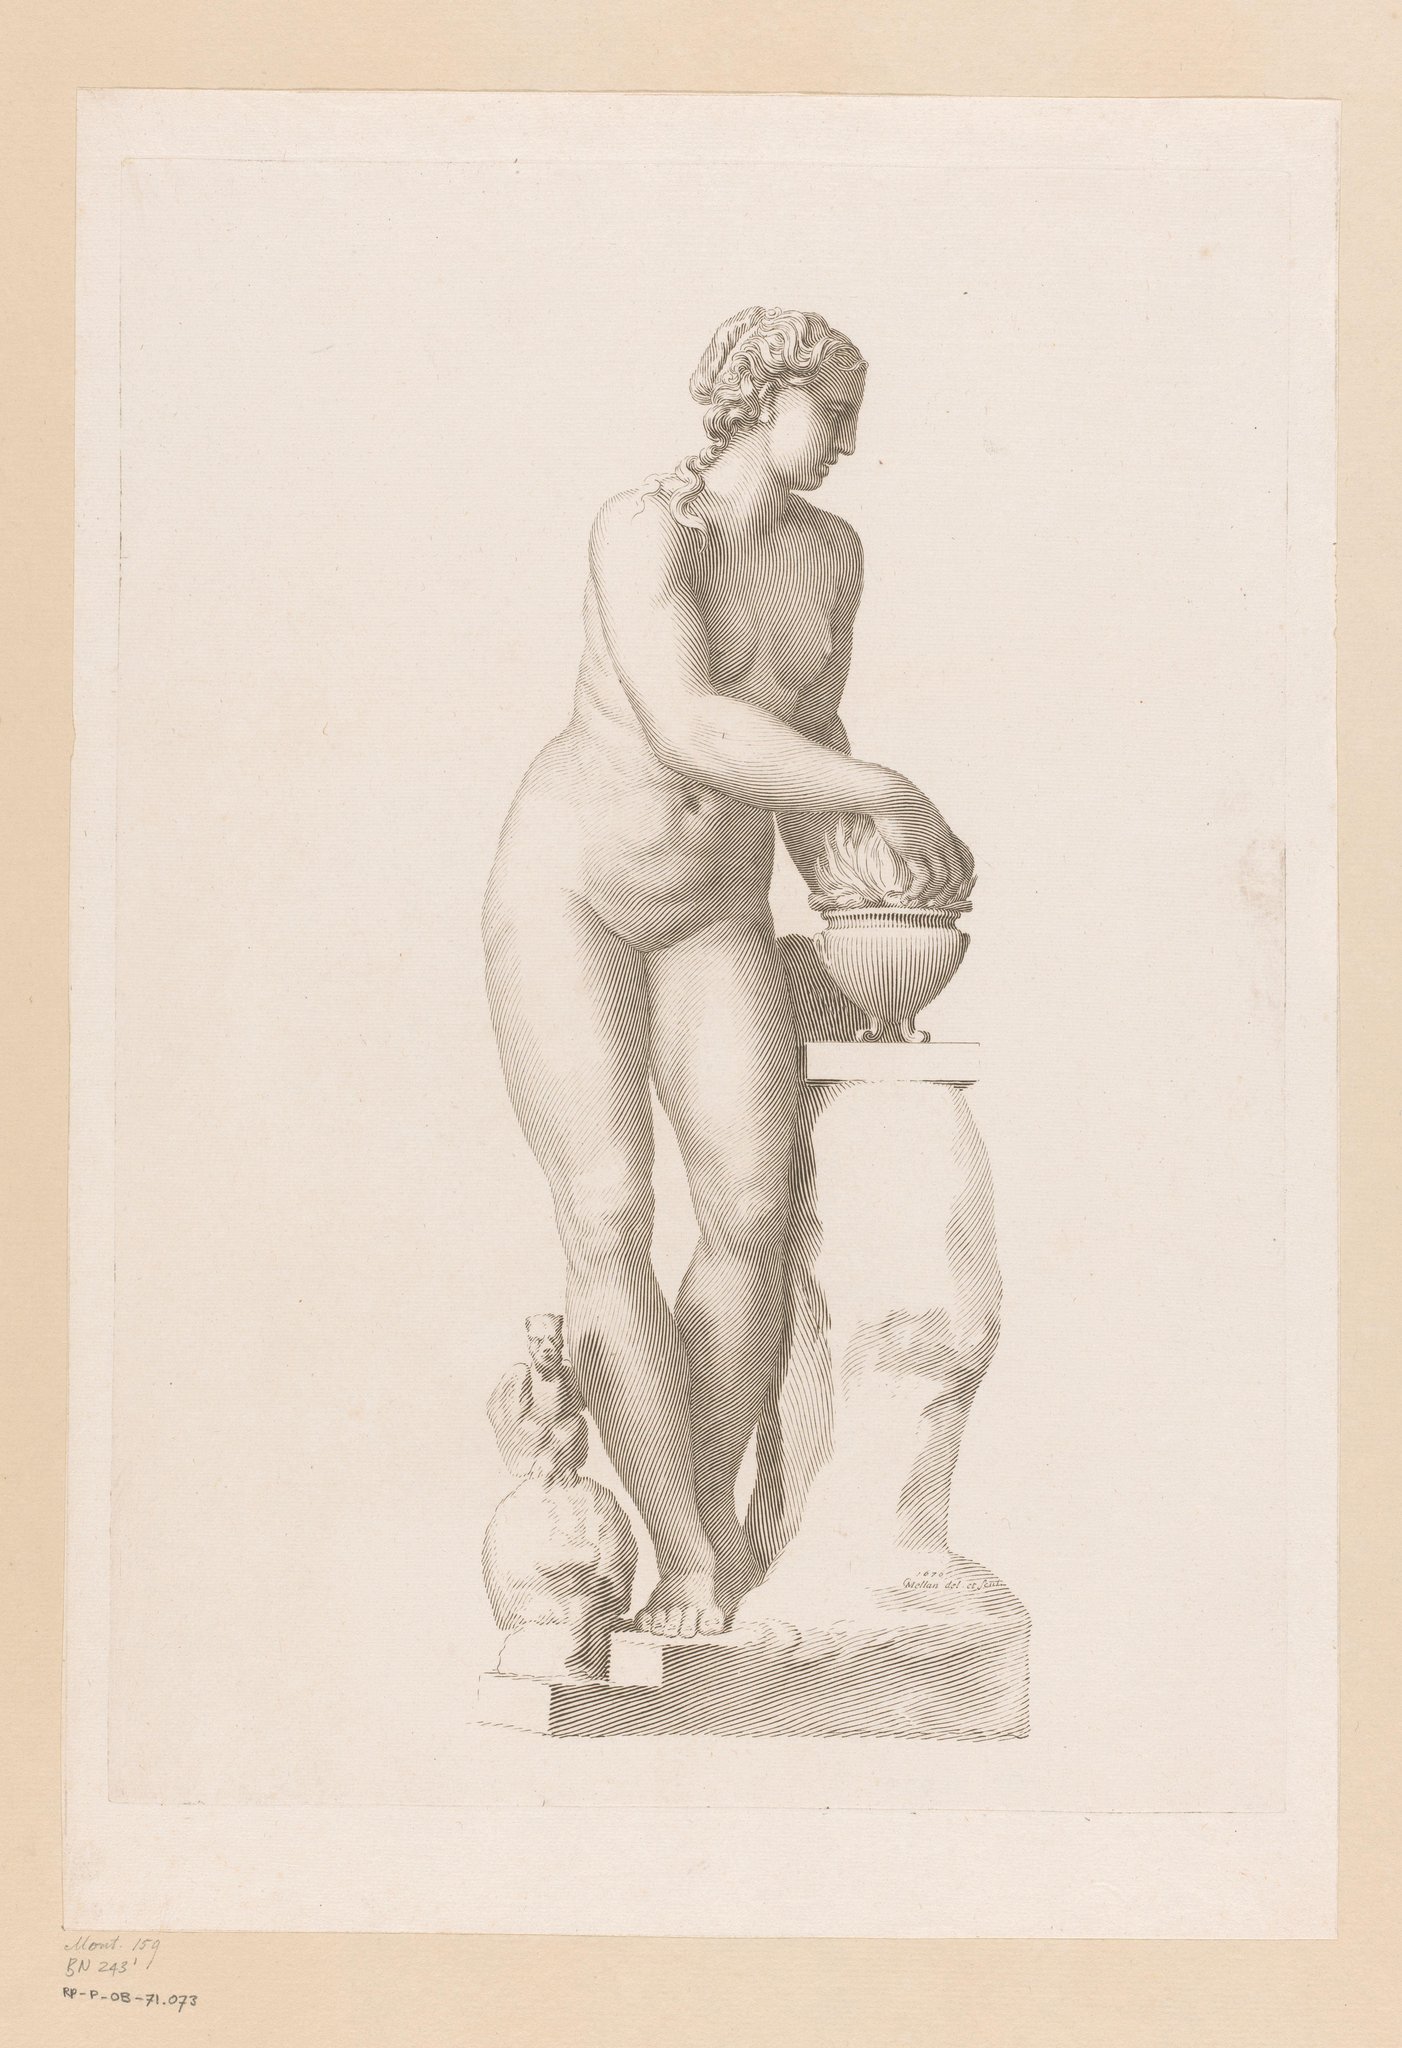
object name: print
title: Standbeeld van Porcia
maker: claude mellan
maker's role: draughtsman, print maker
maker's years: 1598-1688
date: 1670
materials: paper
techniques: engraving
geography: france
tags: (story of) porcia, piece of sculpture, reproduction of a piece of sculpture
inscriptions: collector's mark: Lugt 240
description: Prent gebruikt voor: Félibien, André. Tableaux du Cabinet du roy. Statues et bustes antiques des maisons royales. Parijs: Imprimerie Royale, 1677. Het boek bevat 61 prenten van beelden en bustes uit Franse koninklijke collectie. Mellan vervaardigde in totaal achttien platen (zie ook British Museum, inv.nr. 1874,0808.1488). Het beeld bevindt zich in Versailles.